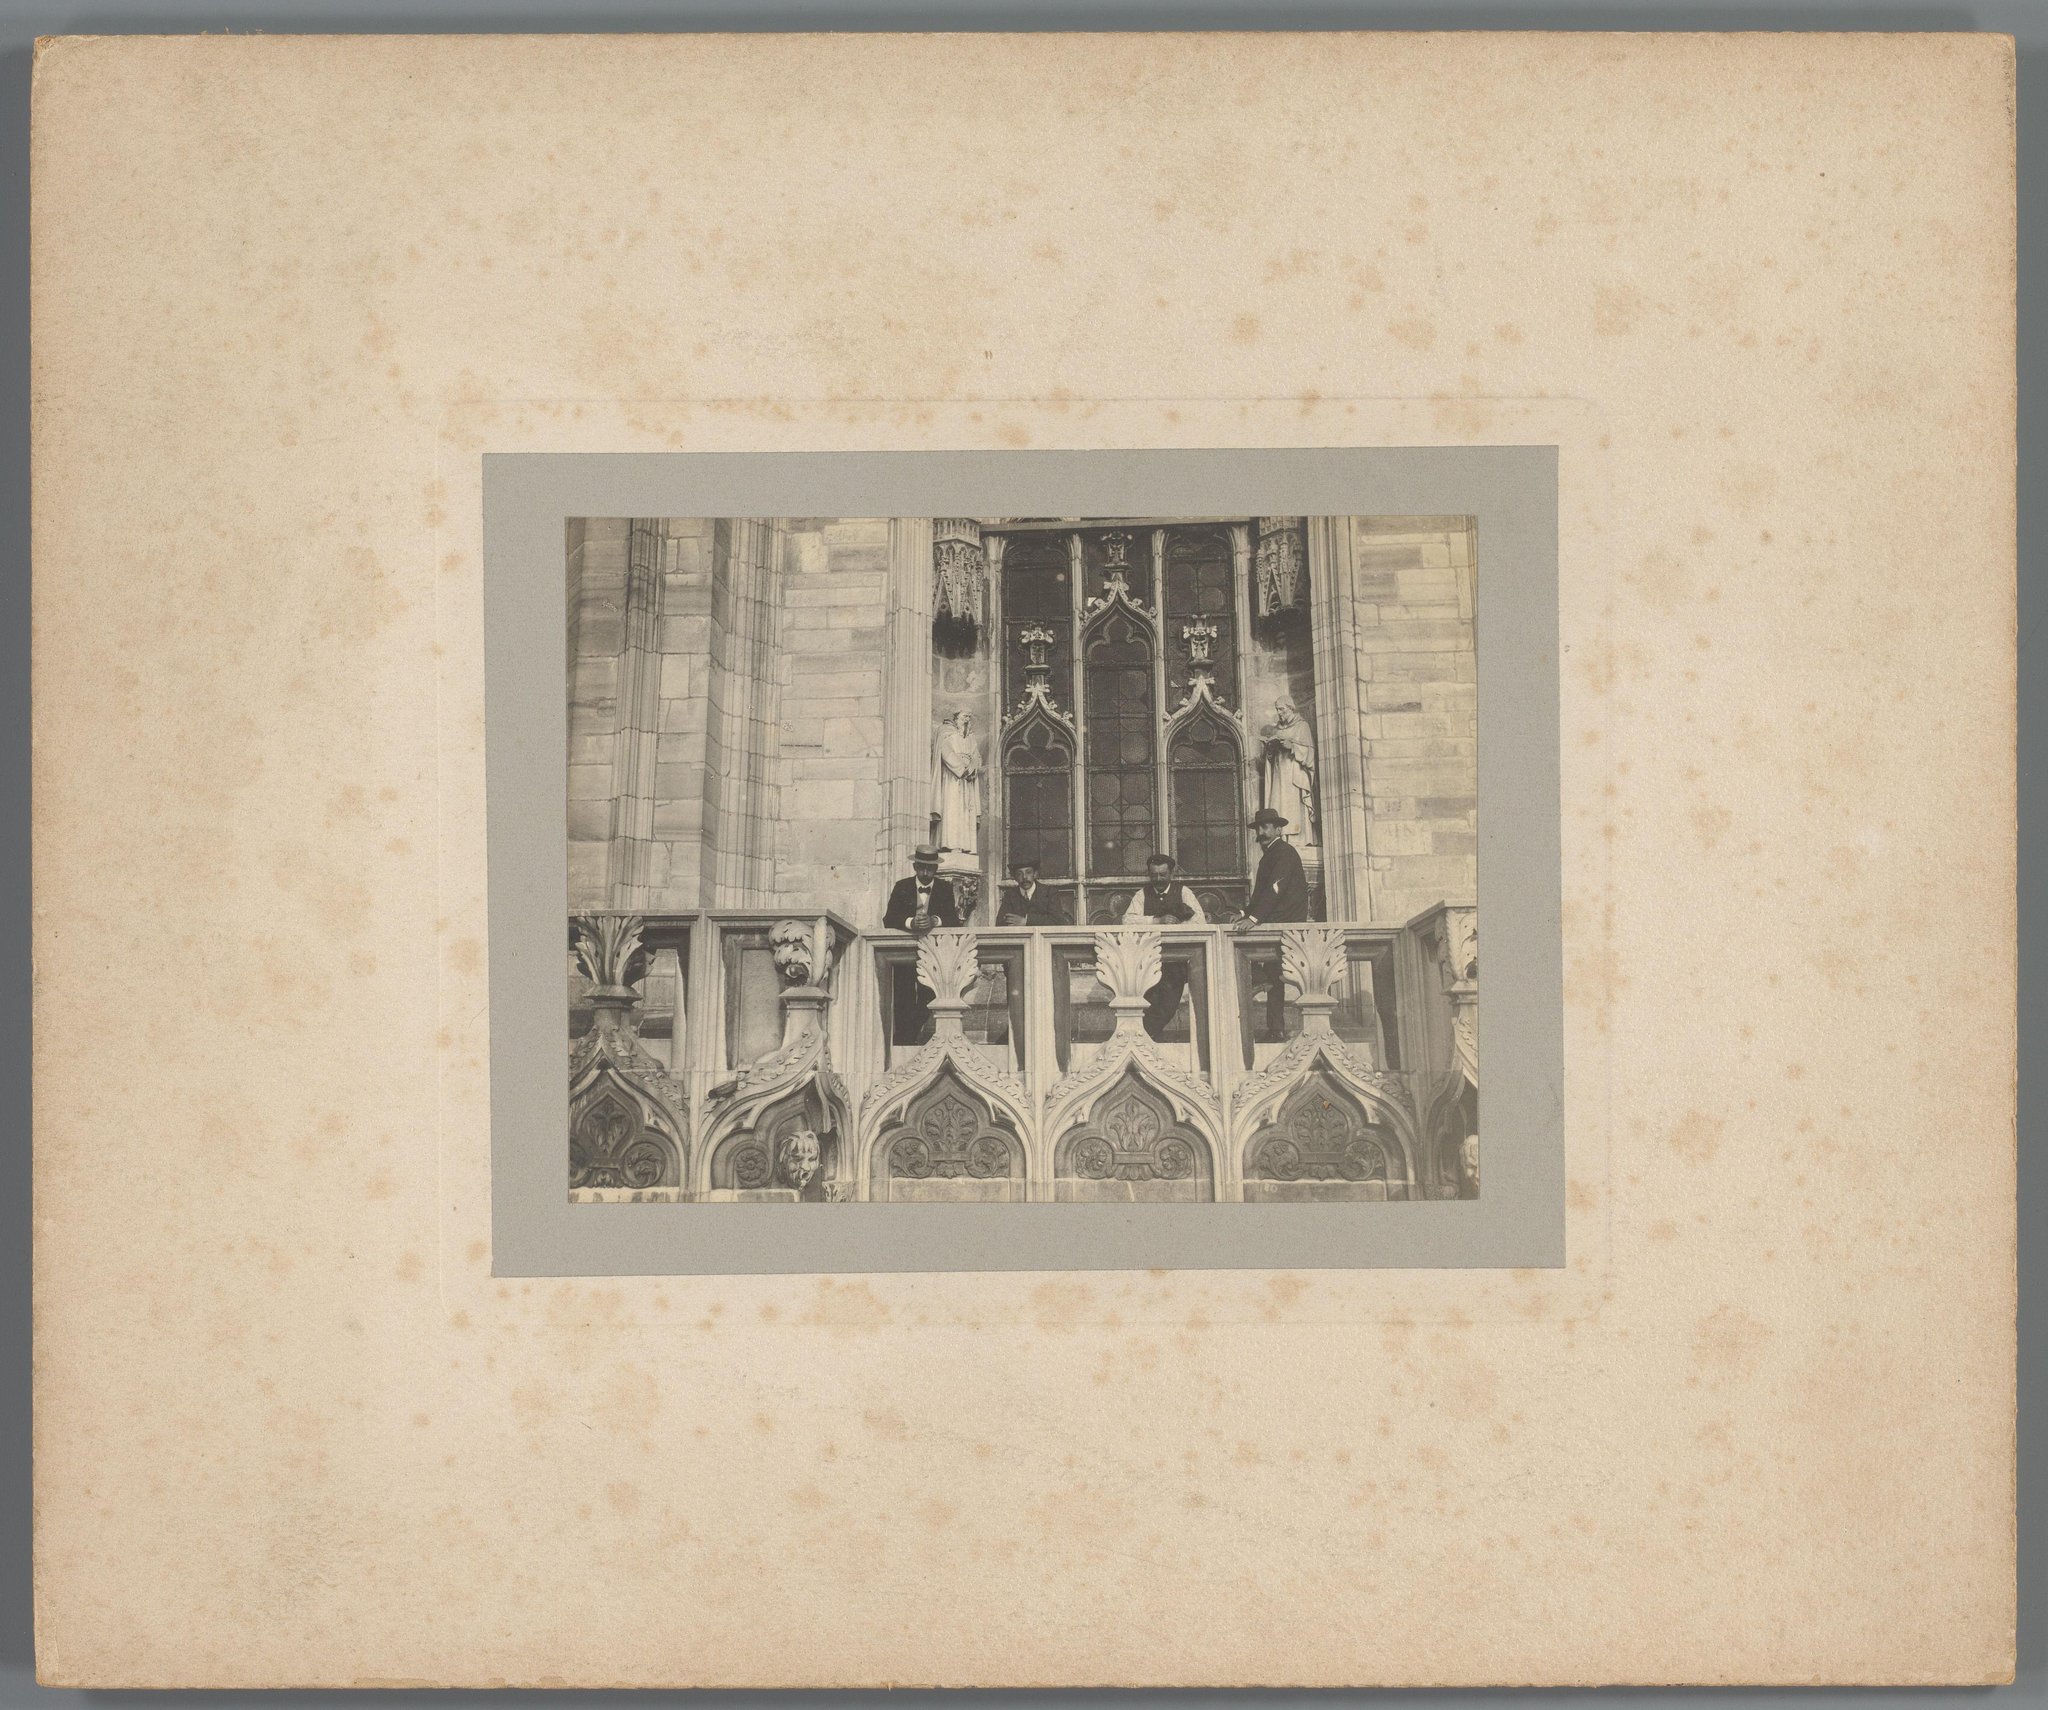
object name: photograph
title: Groepsportret van vier onbekende mannen op de Dom van Milaan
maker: françois buys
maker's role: advocaat, amateurfotograaf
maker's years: 1871-1934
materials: paper, cardboard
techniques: gelatin silver print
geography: milan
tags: anonymous historical persons portrayed in a group, in a group-portrait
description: Deze foto maakt deel uit van een groep van 38 foto's.